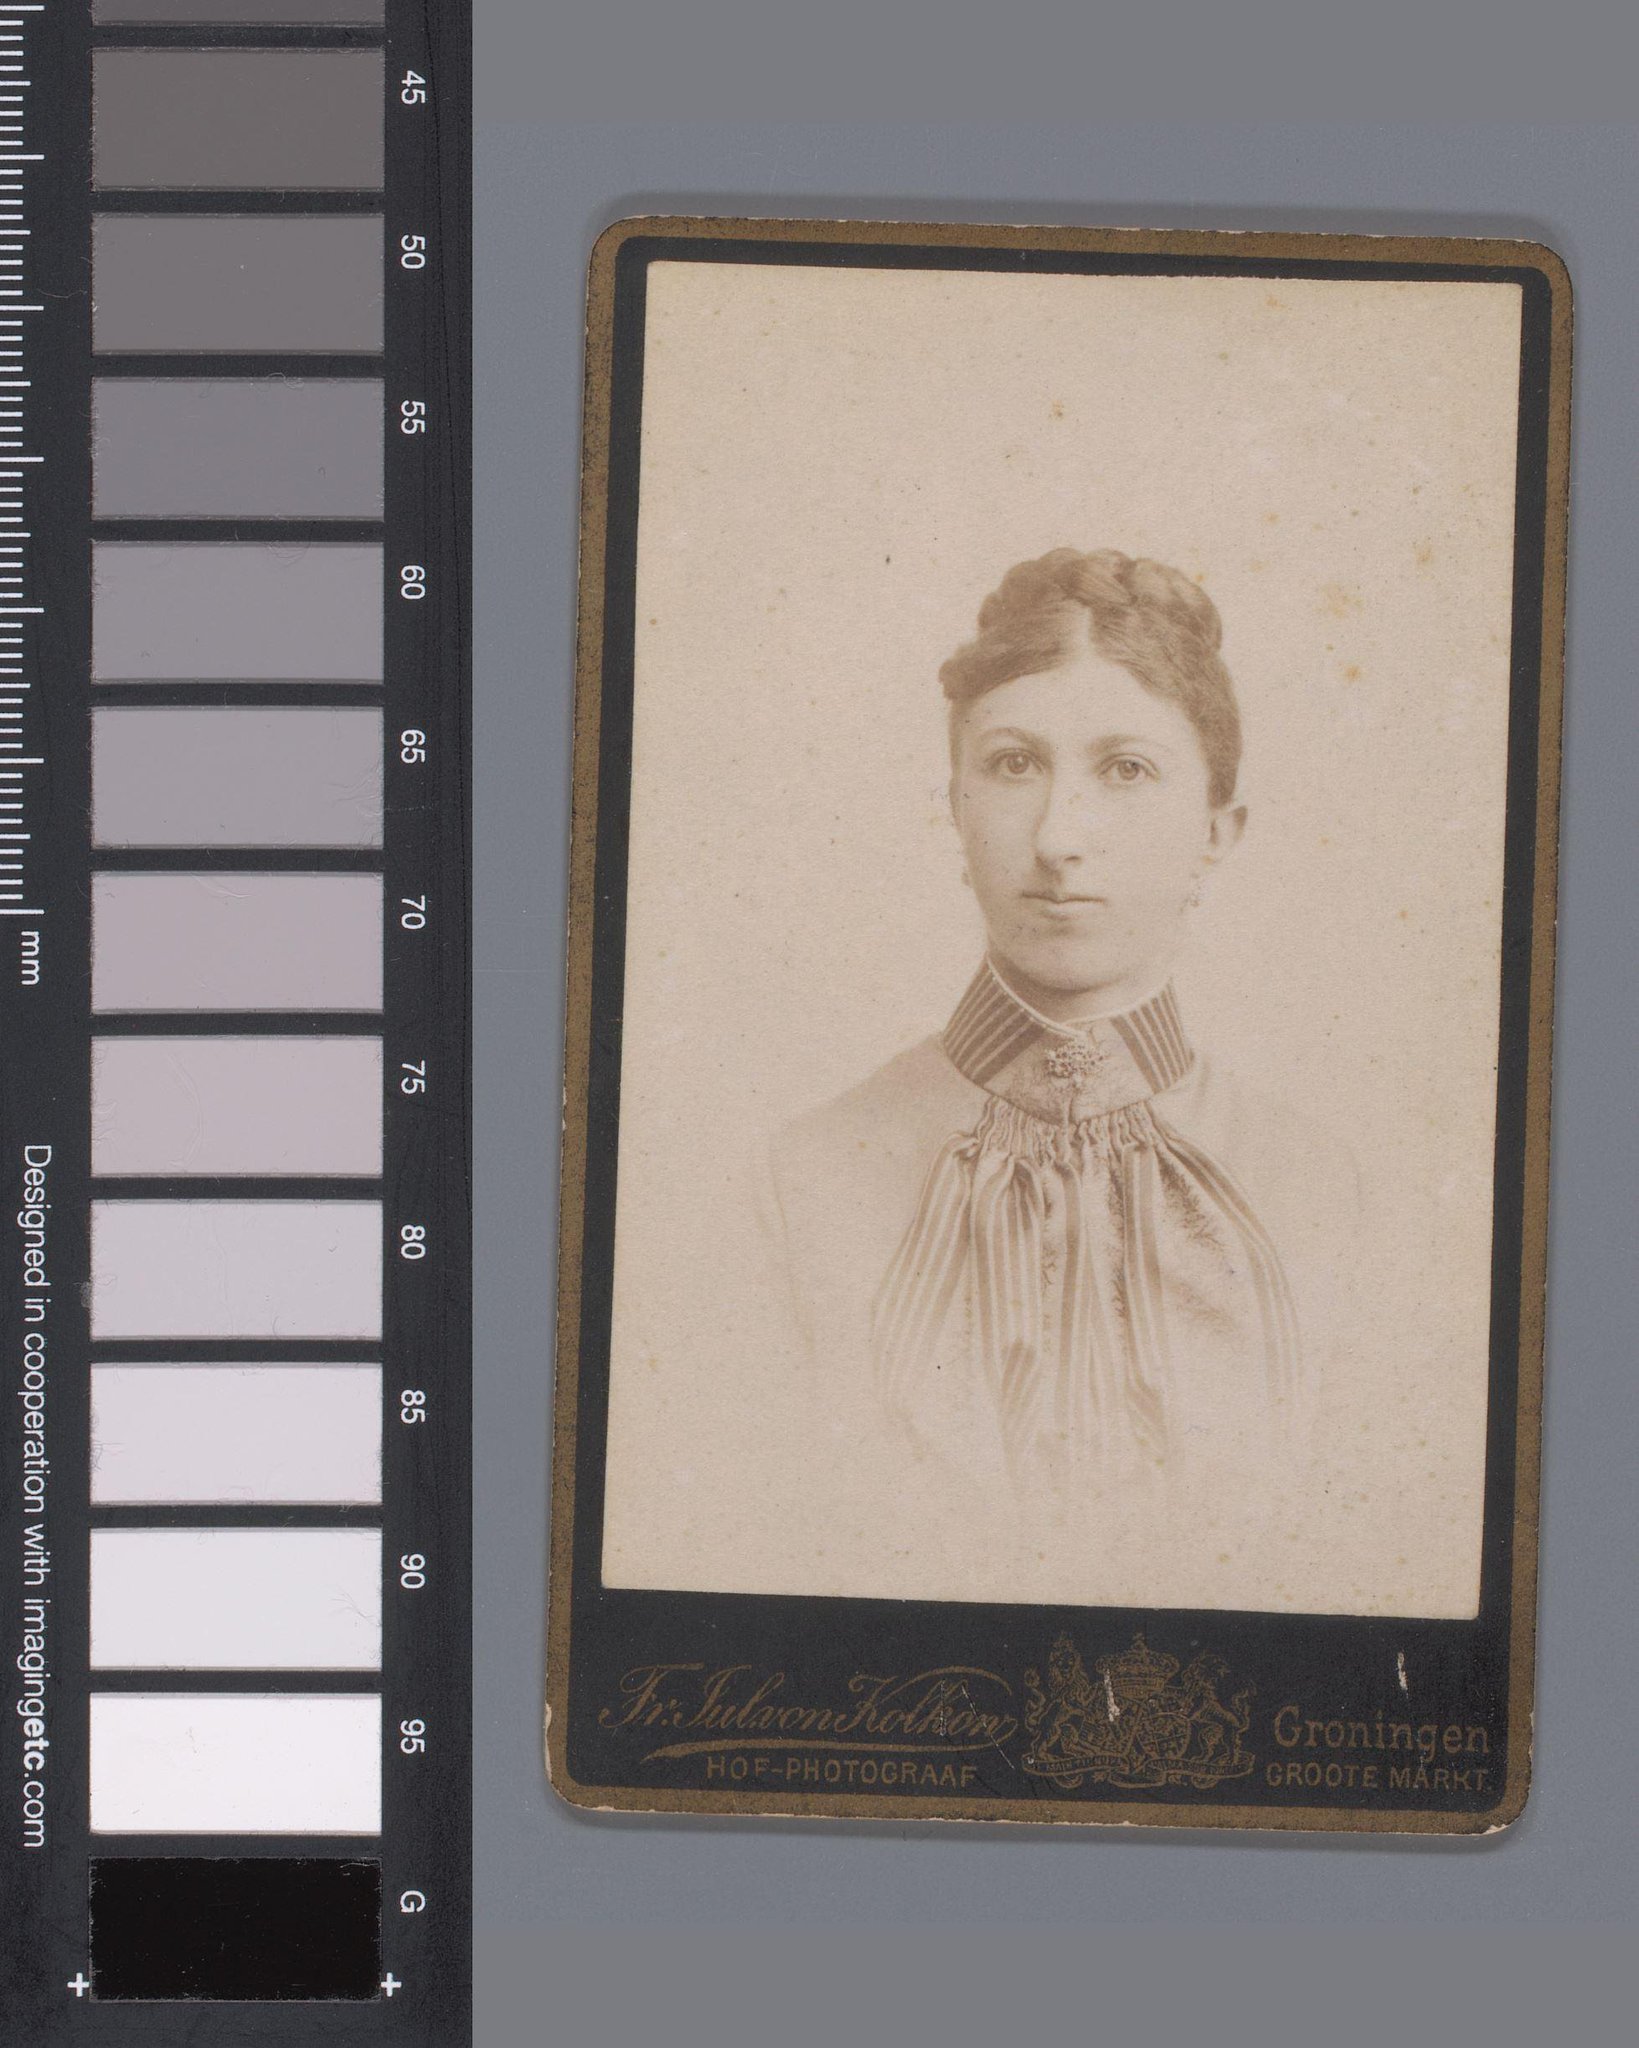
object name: carte de visite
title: Portret van Dietje Zijlema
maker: friedrich julius von kolkow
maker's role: fotograaf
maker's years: 1839-1914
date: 1884-1896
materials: cardboard, paper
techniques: albumen print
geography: groningen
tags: historical persons - bb - woman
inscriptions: inscription: ‘Dietje Zijlema/ later get. met/ Veenland, Drachten’, inscription: ‘GOUDEN MEDALJE VOOR KUNST EN WETENSCHAP v Z. M. de KONING v WÜRTTEMBERG/ aan het lint der Frederiksorde/ PHILADELPHIA 1876. WIEN 1873./ FR. JUL. VON KOLKOW/ KONINKLIJK NEDERLANDSCH HOF-PHOTOGRAPH/ Silberne Voigtländer Medaille Kunst u Wissenschaft Oldenburg/ en tien zilveren Medaljes op andere Tentoonstellingen./ GRONINGEN/ Groote Markt bij de/ Martinitoorn./ Specialiteit in Vergrootingen.’